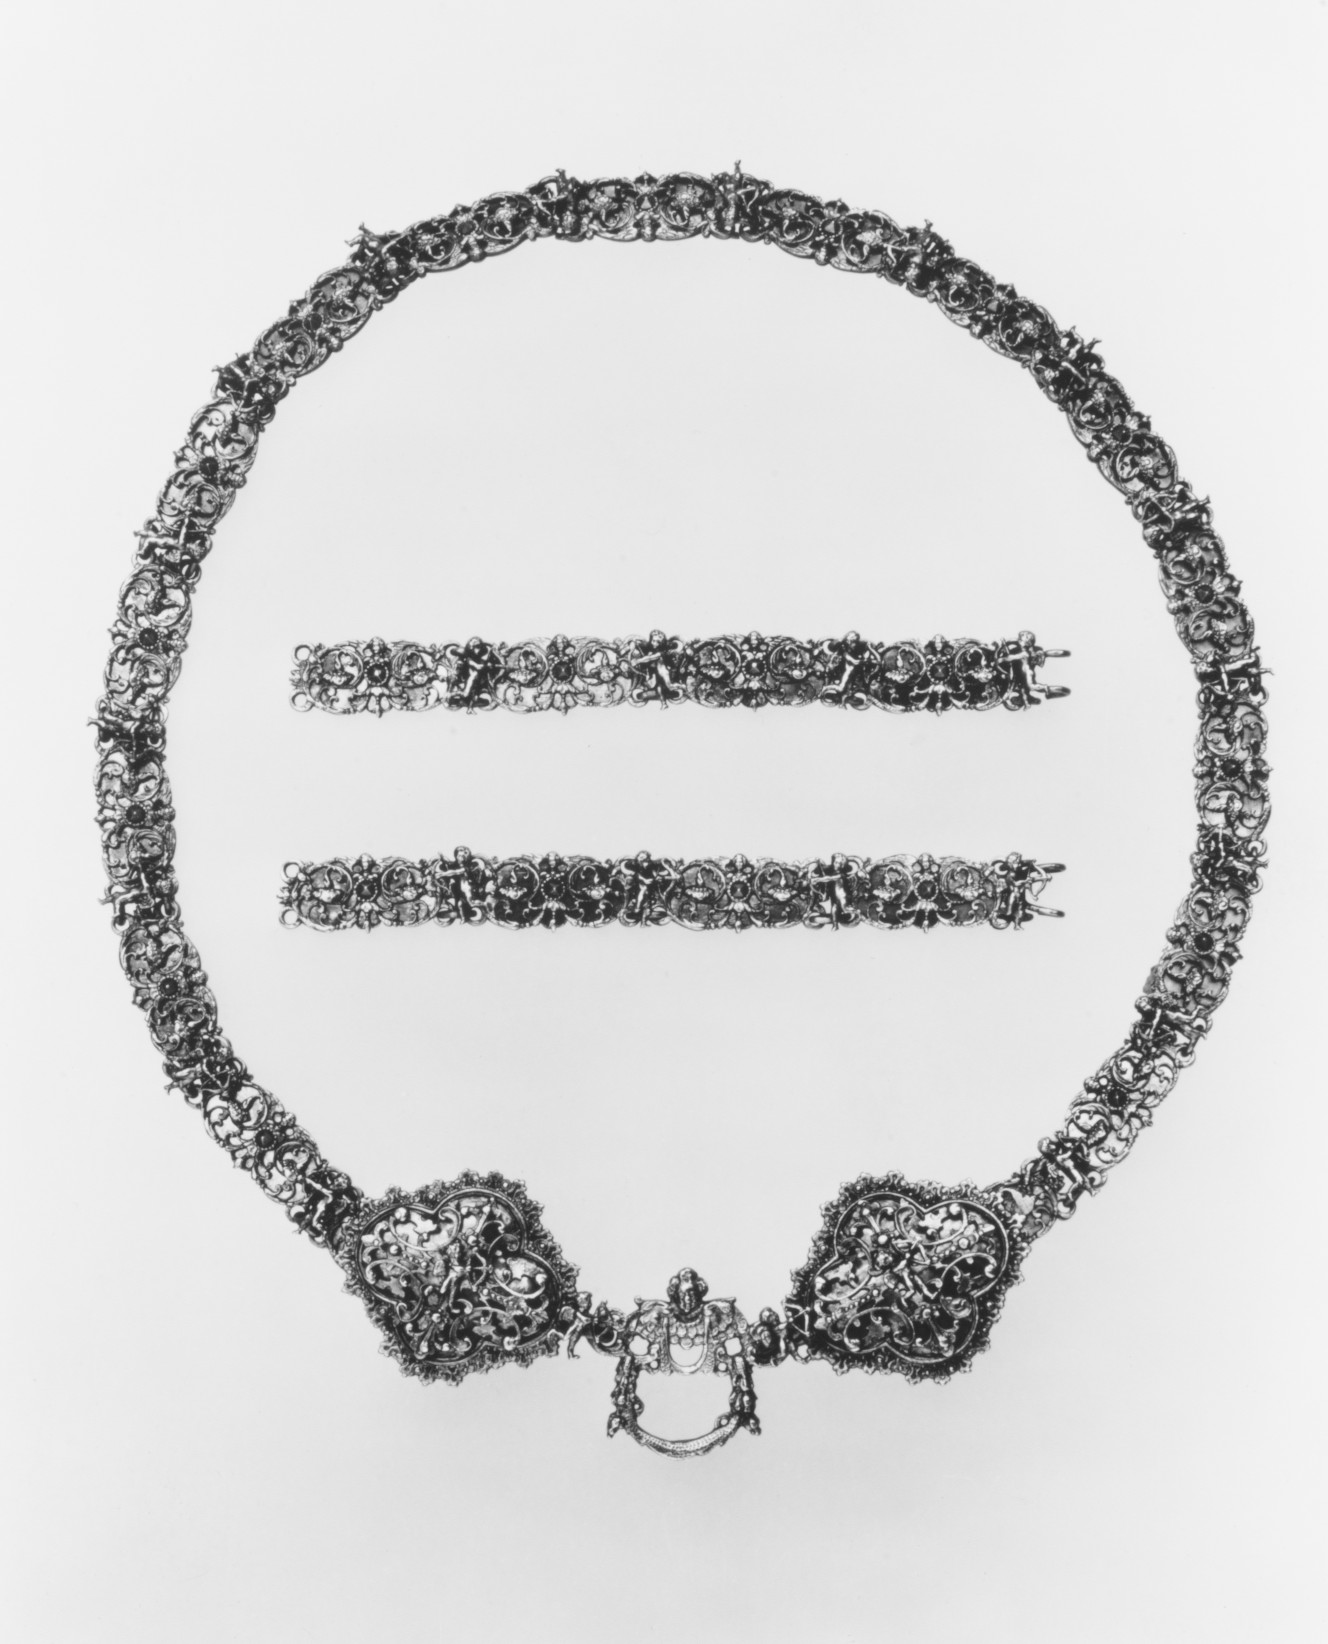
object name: girdle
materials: silver gilt